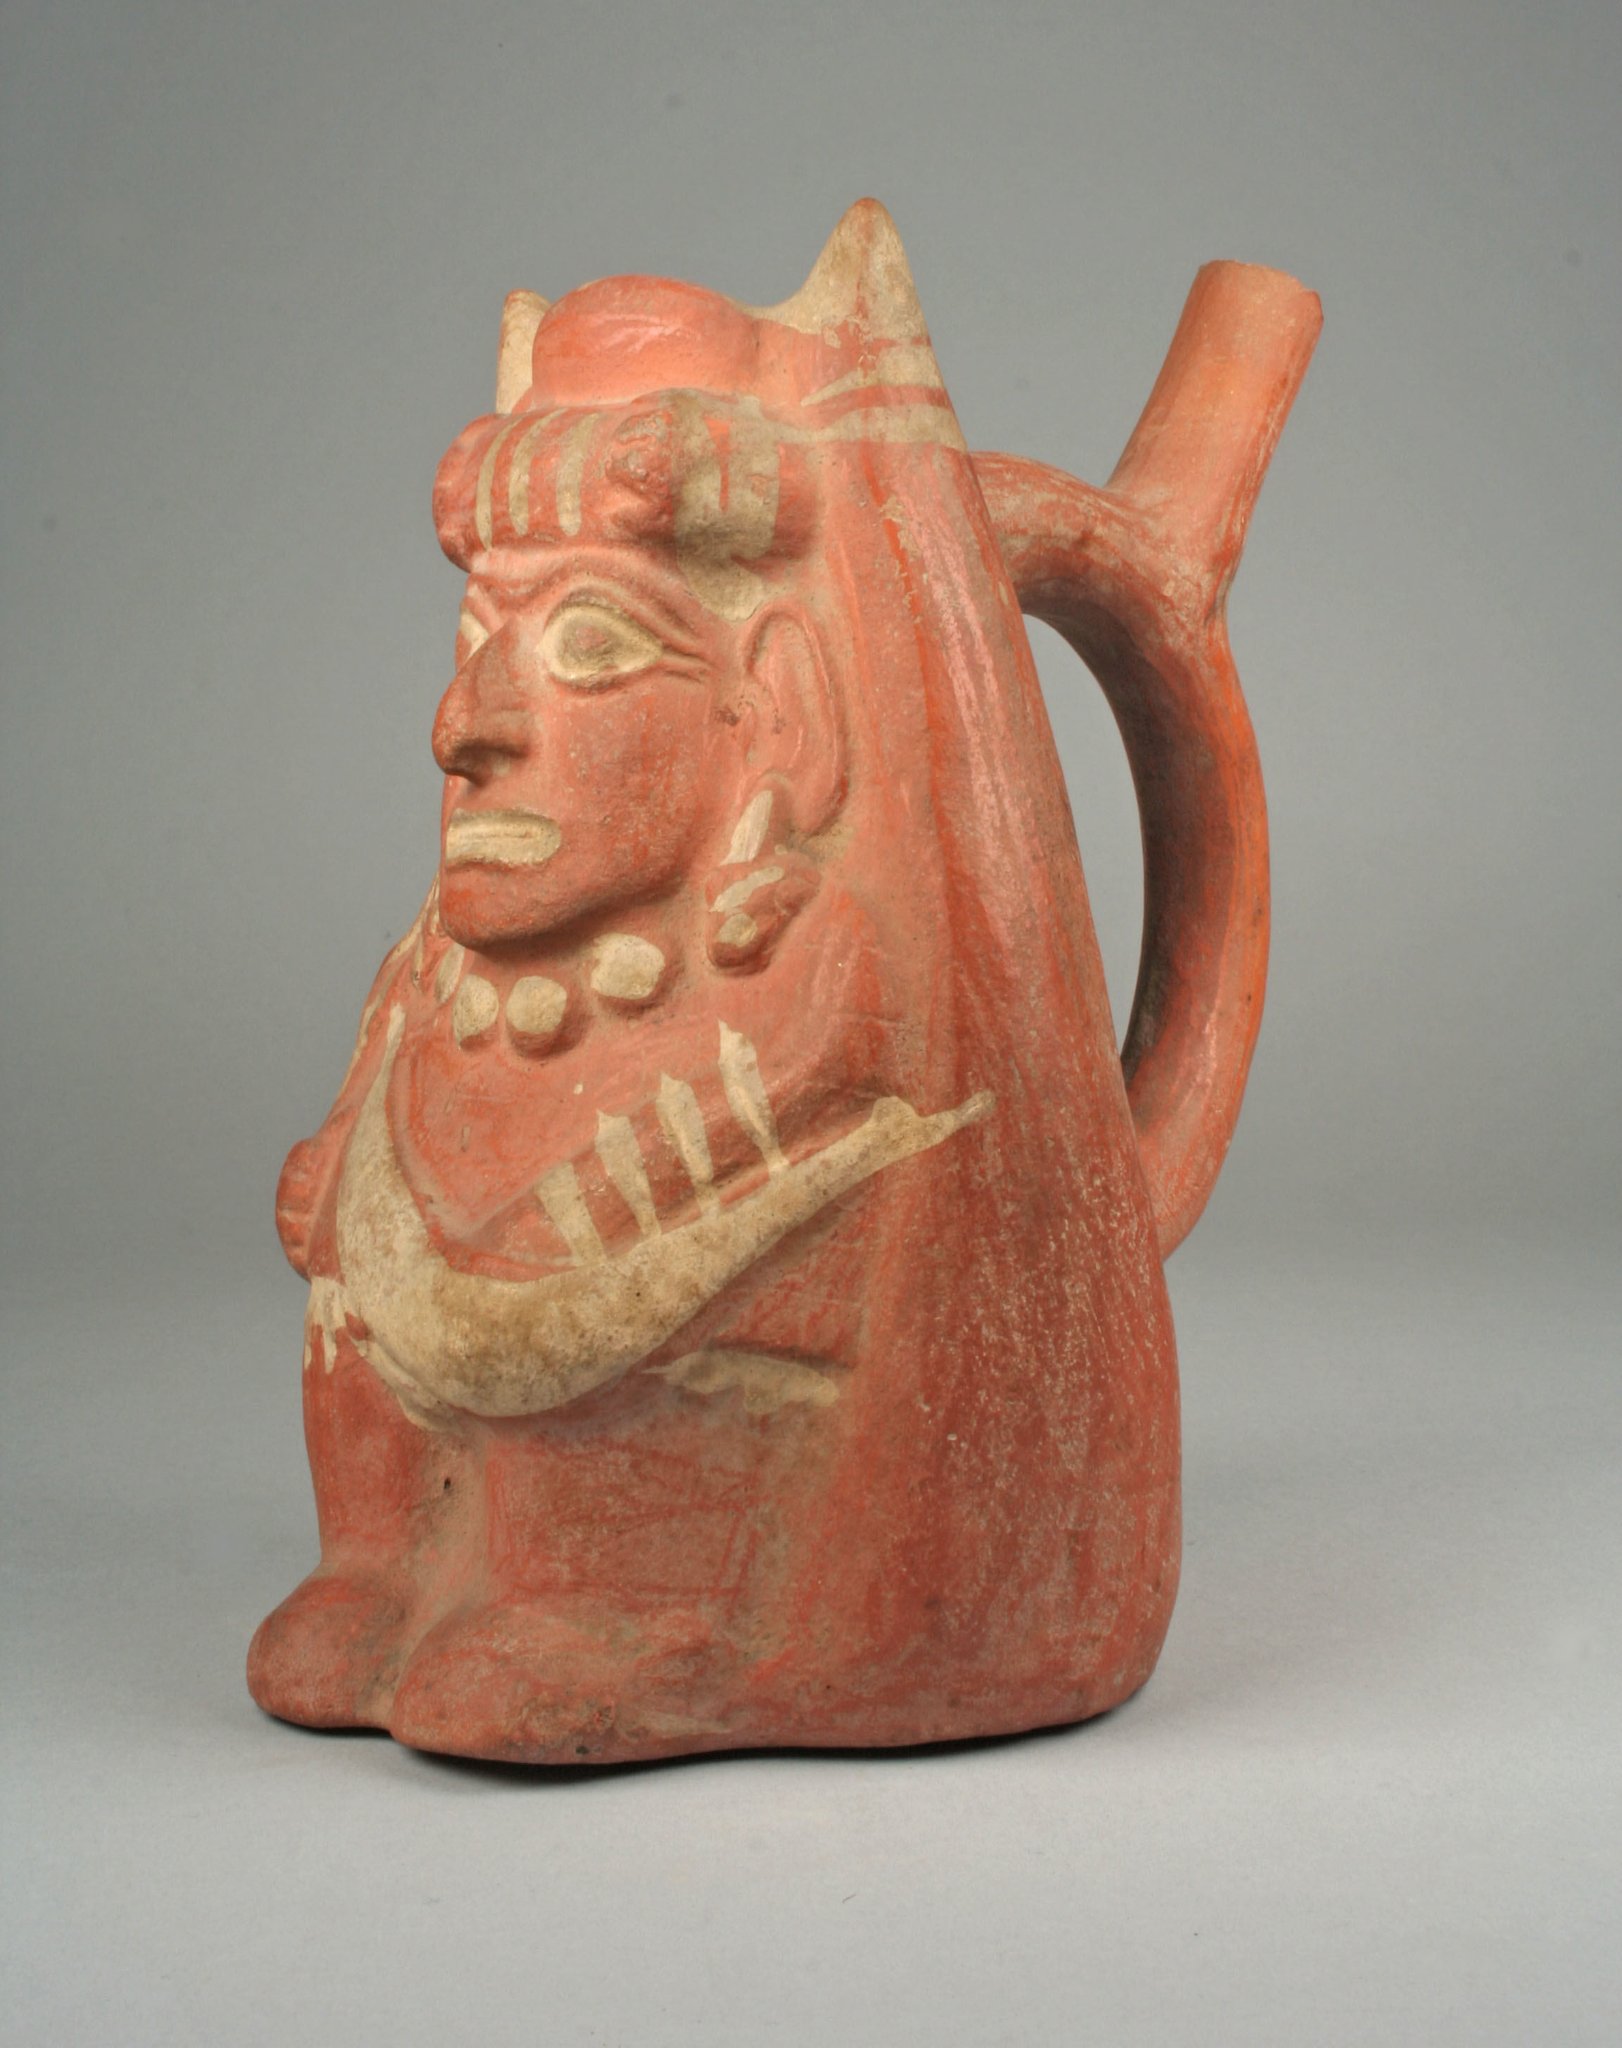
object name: bottle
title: Stirrup Spout Bottle with Figure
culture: moche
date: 301-600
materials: ceramic, pigment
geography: peru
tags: human figures